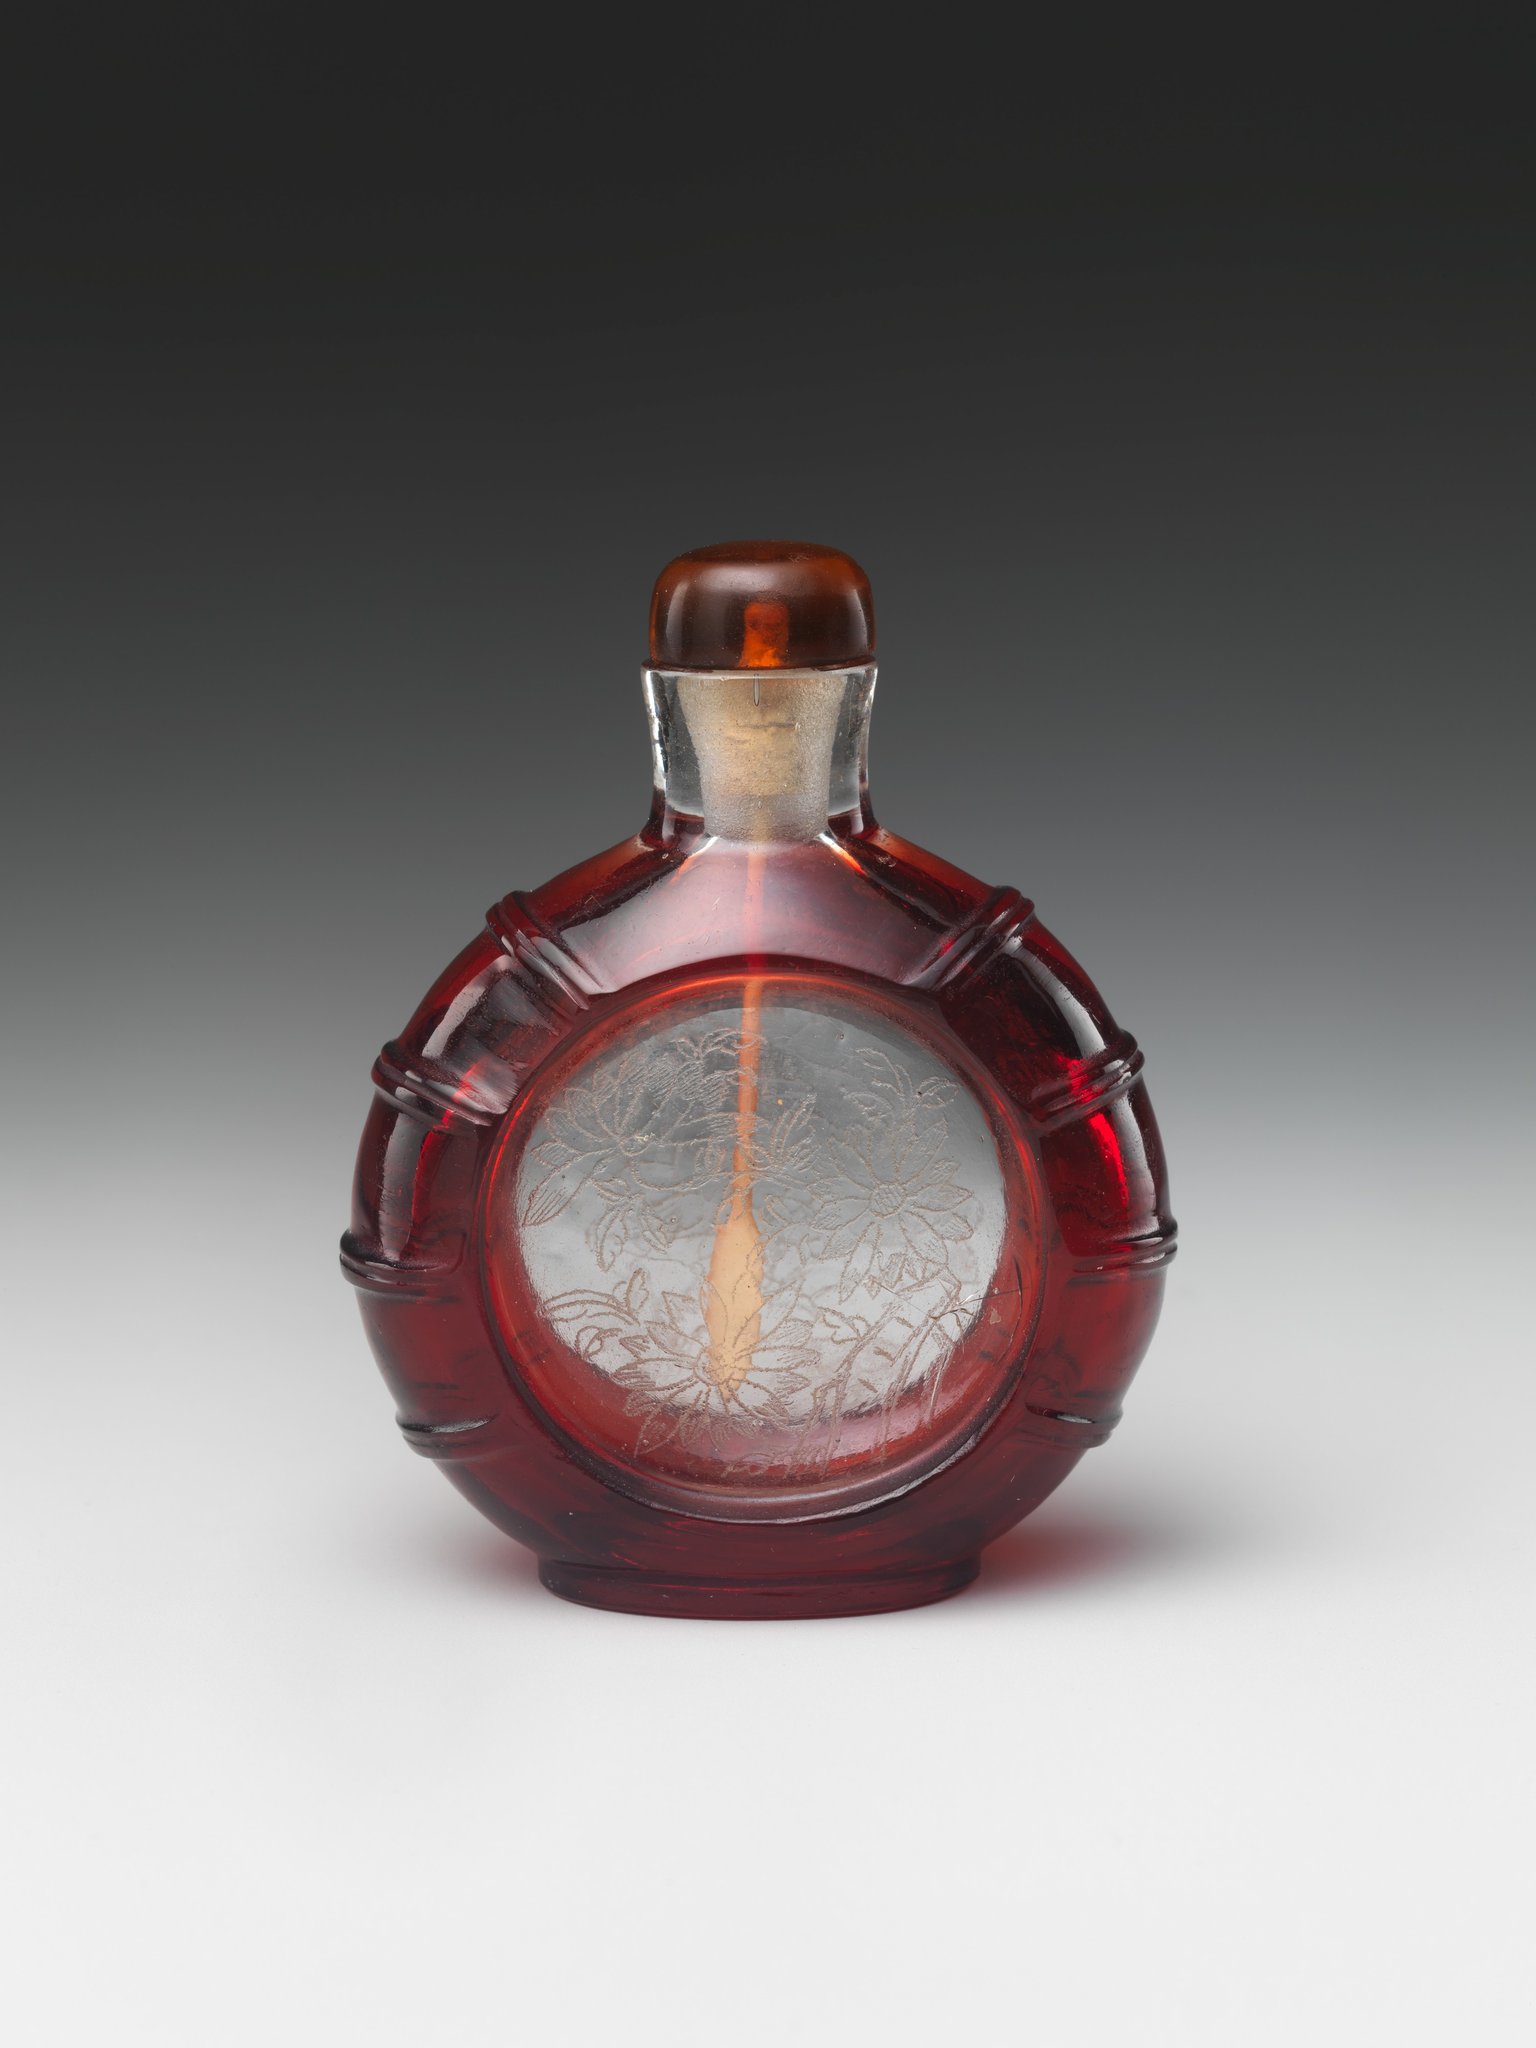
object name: snuff bottle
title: Snuff Bottle with Floral Design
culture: chinese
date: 1767-1800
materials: glass